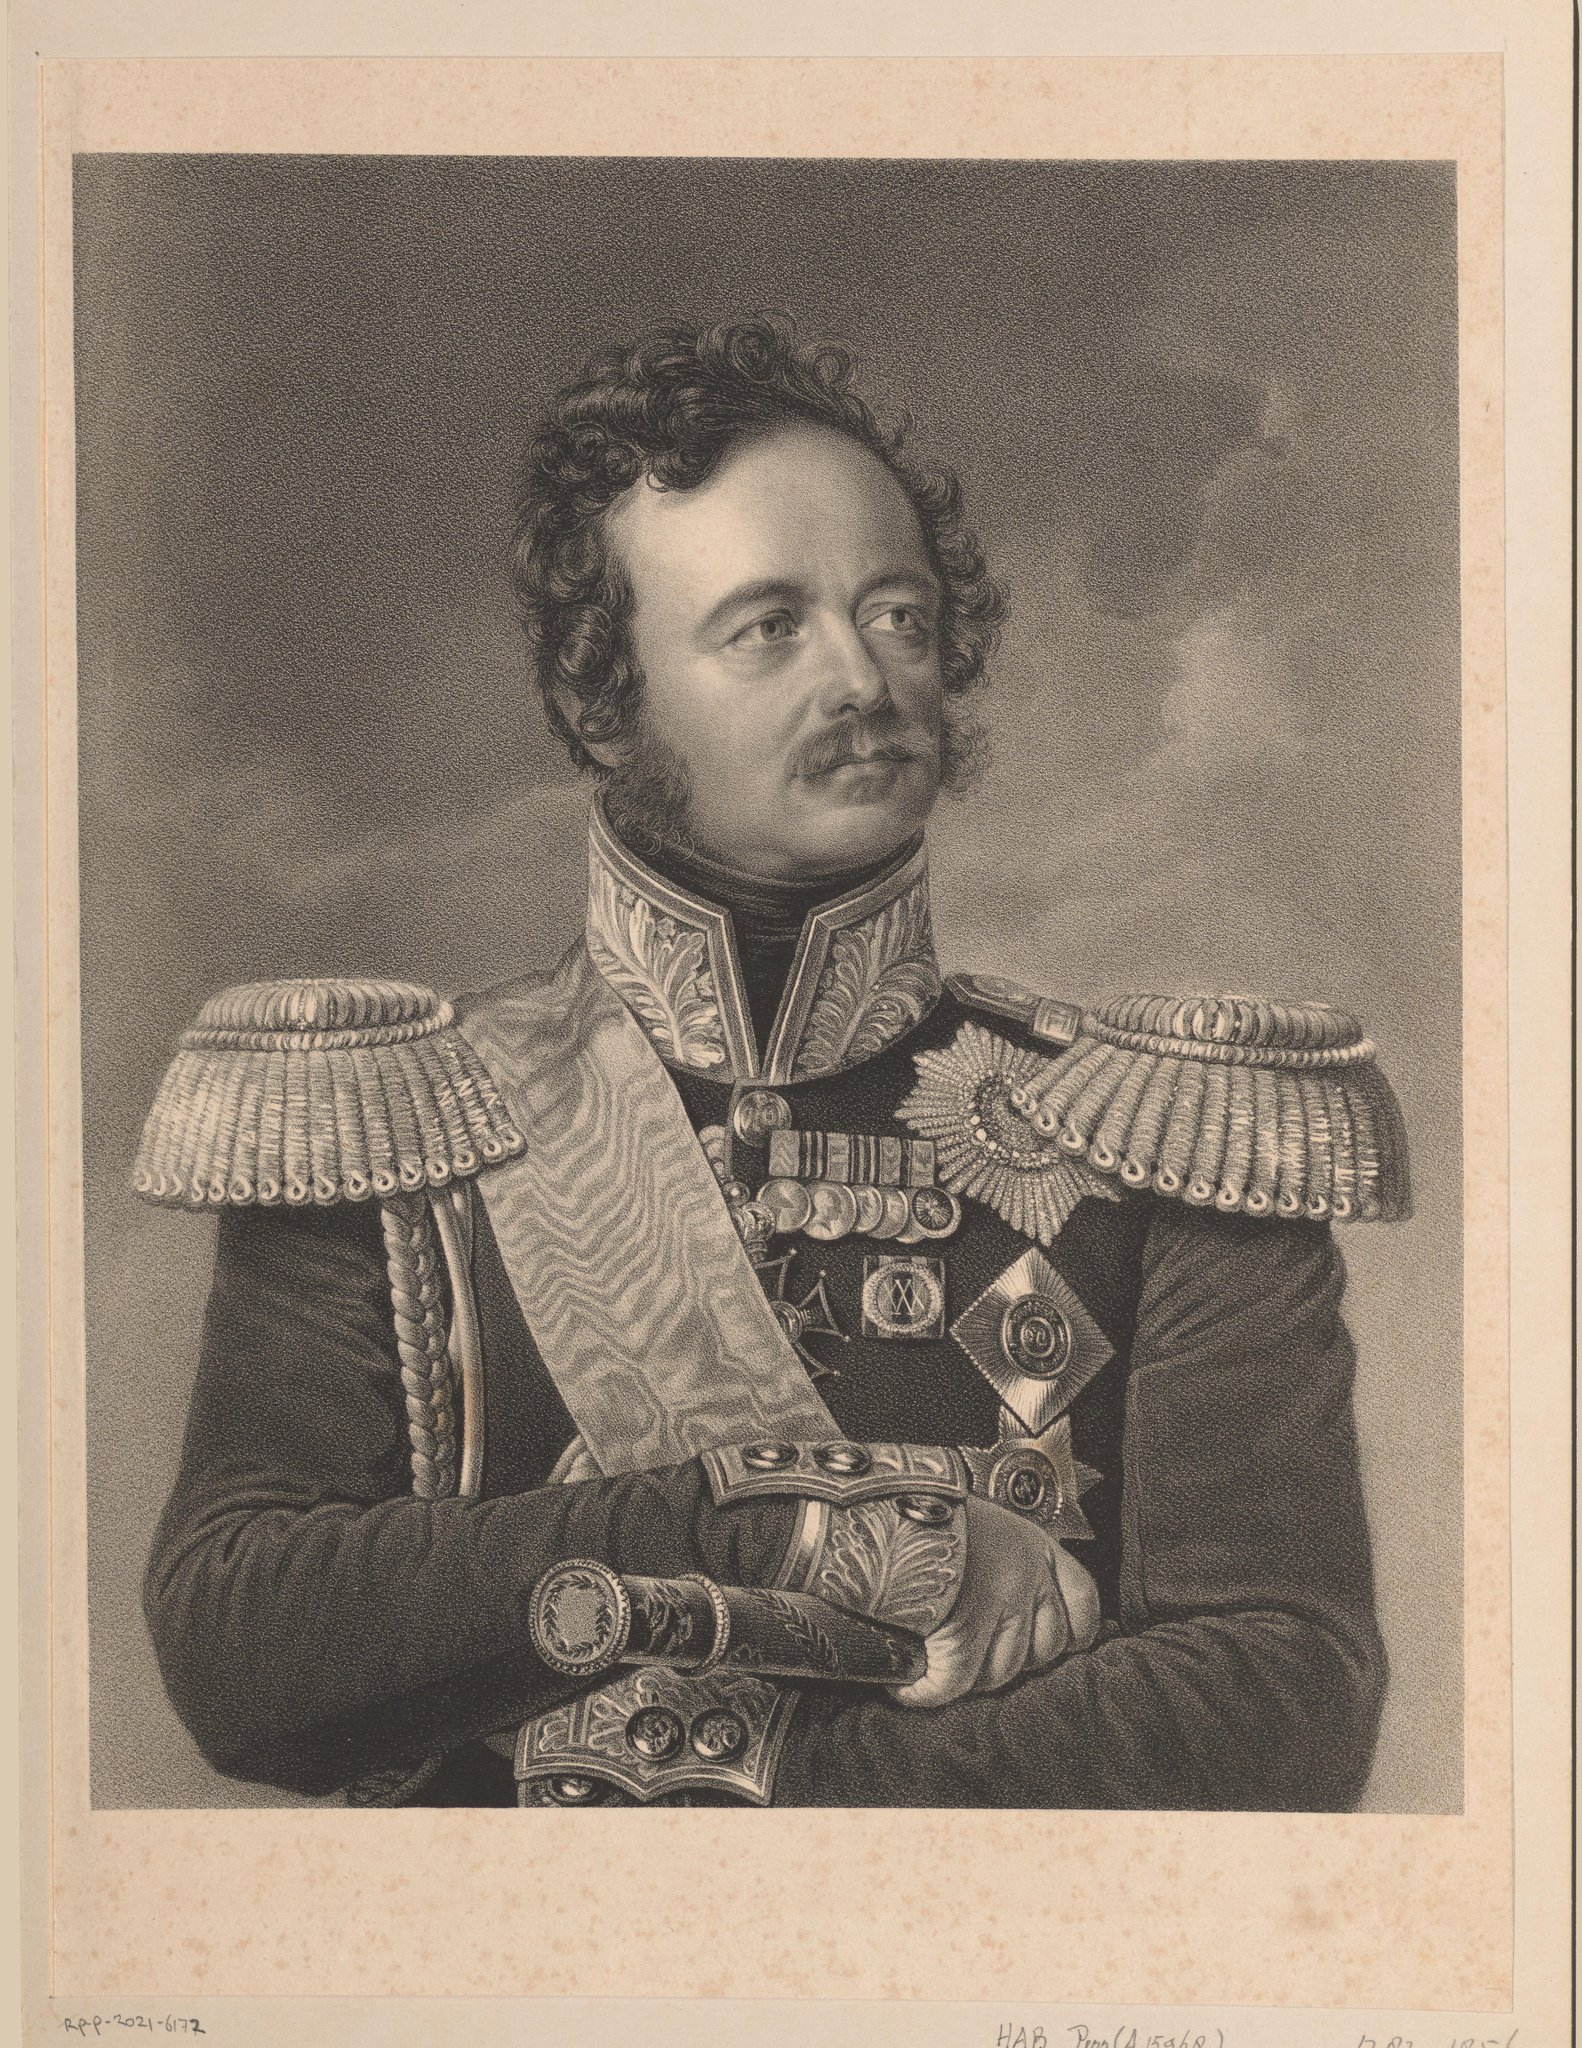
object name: print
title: Portret van Ivan Paskevitsj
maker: Anonymous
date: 1834-1874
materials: paper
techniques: lithograph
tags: earl, politician, adult man, historical persons, (military) uniforms